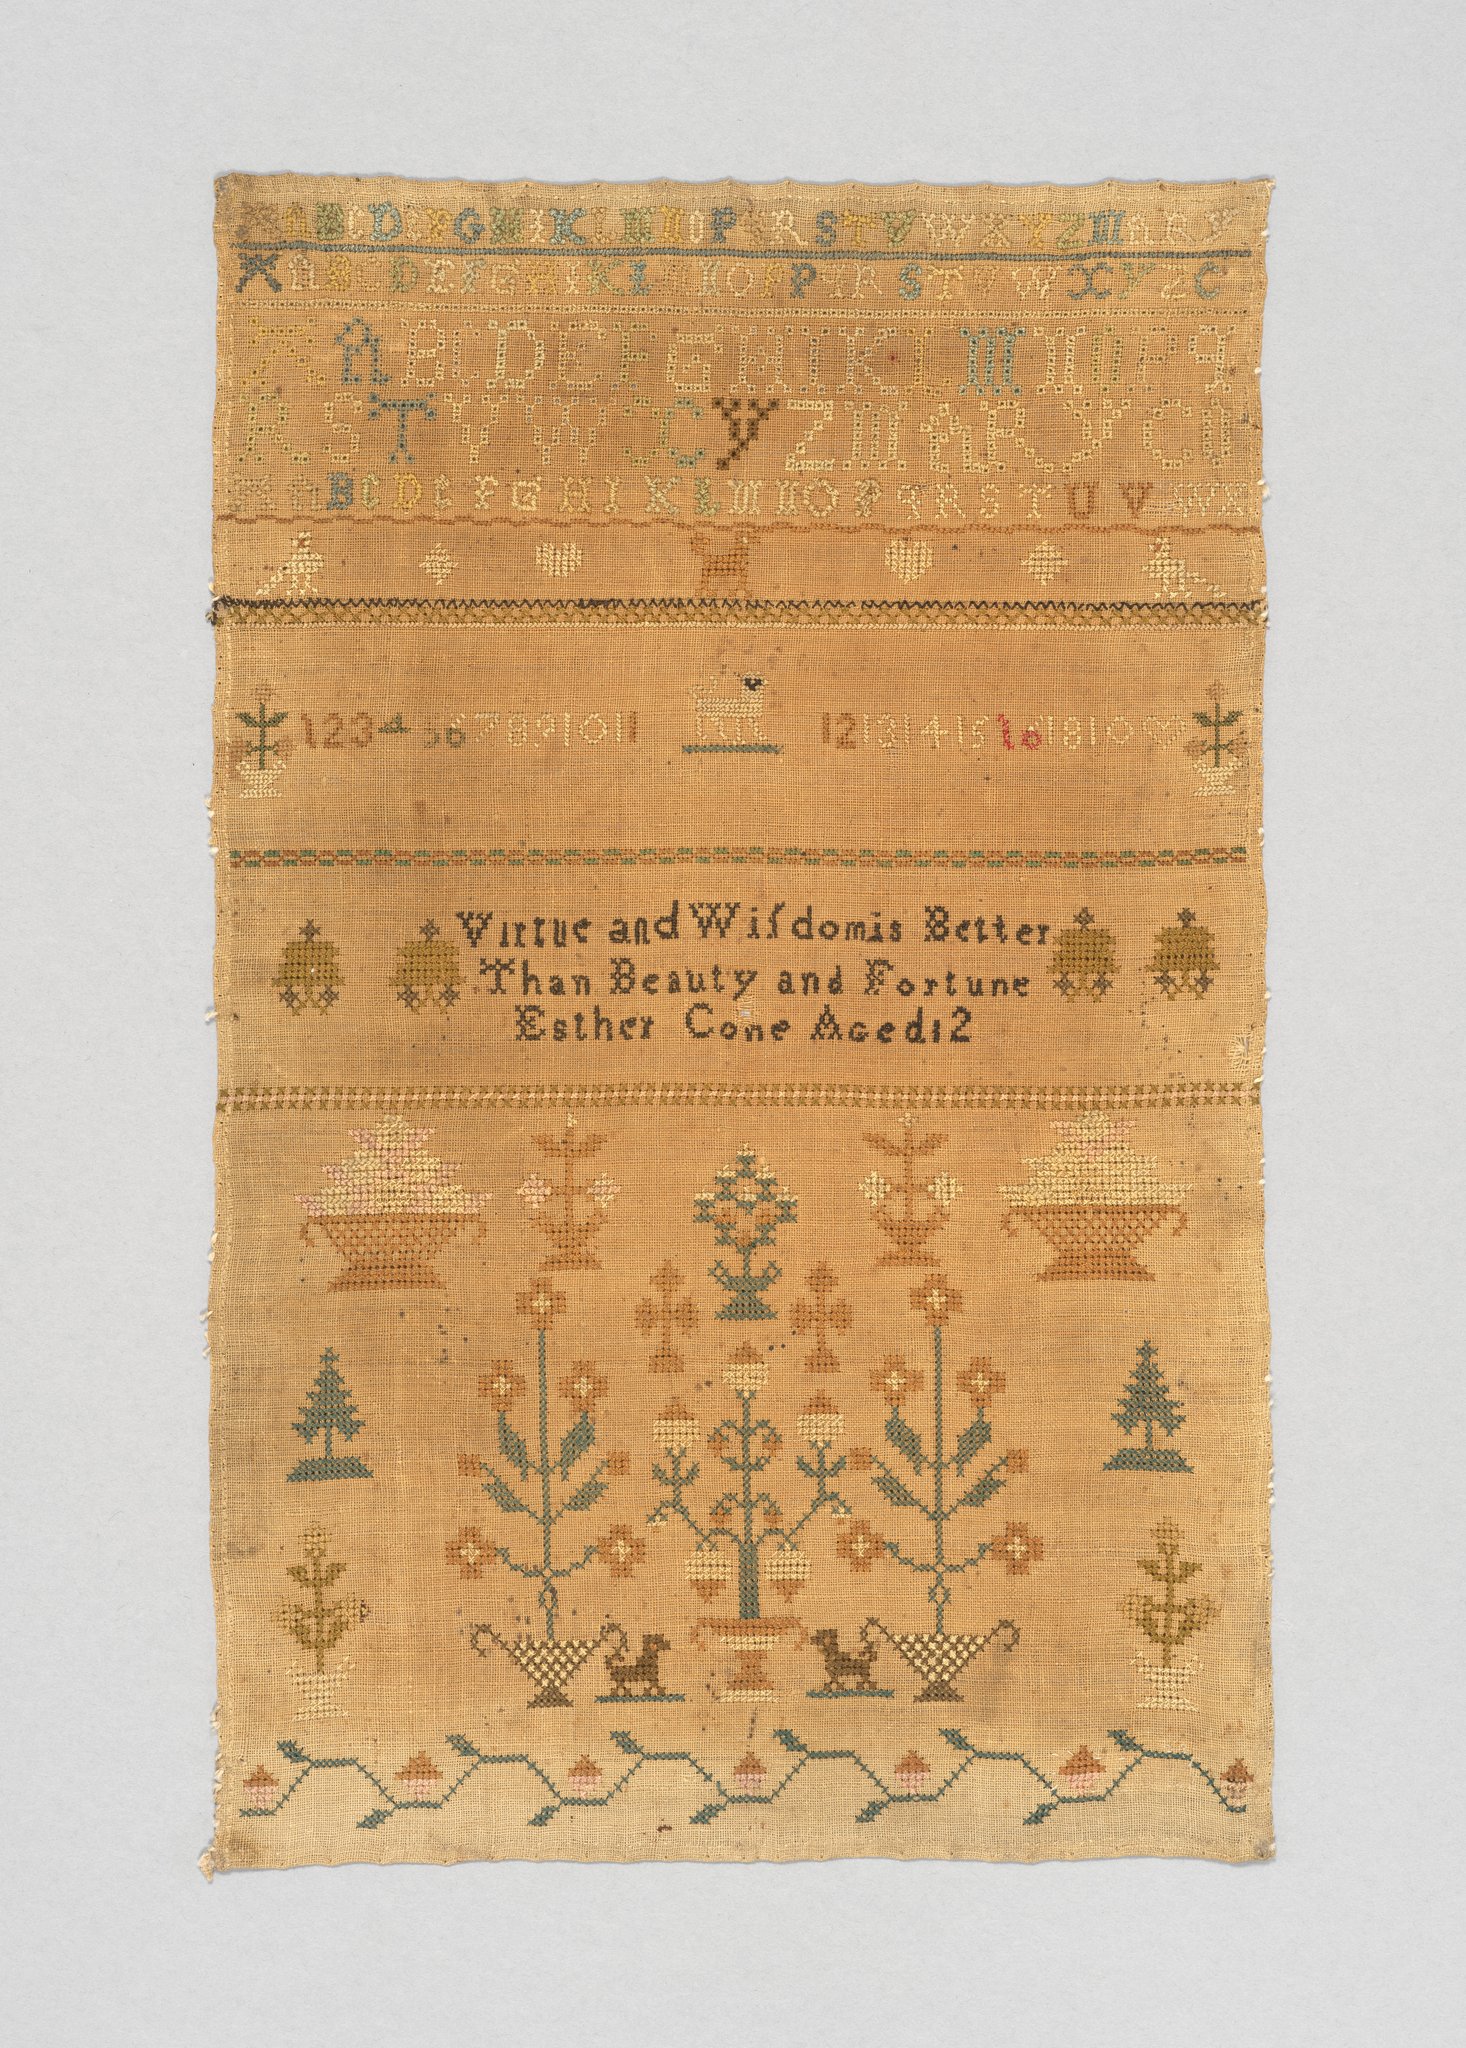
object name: sampler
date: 1810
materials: linen, silk